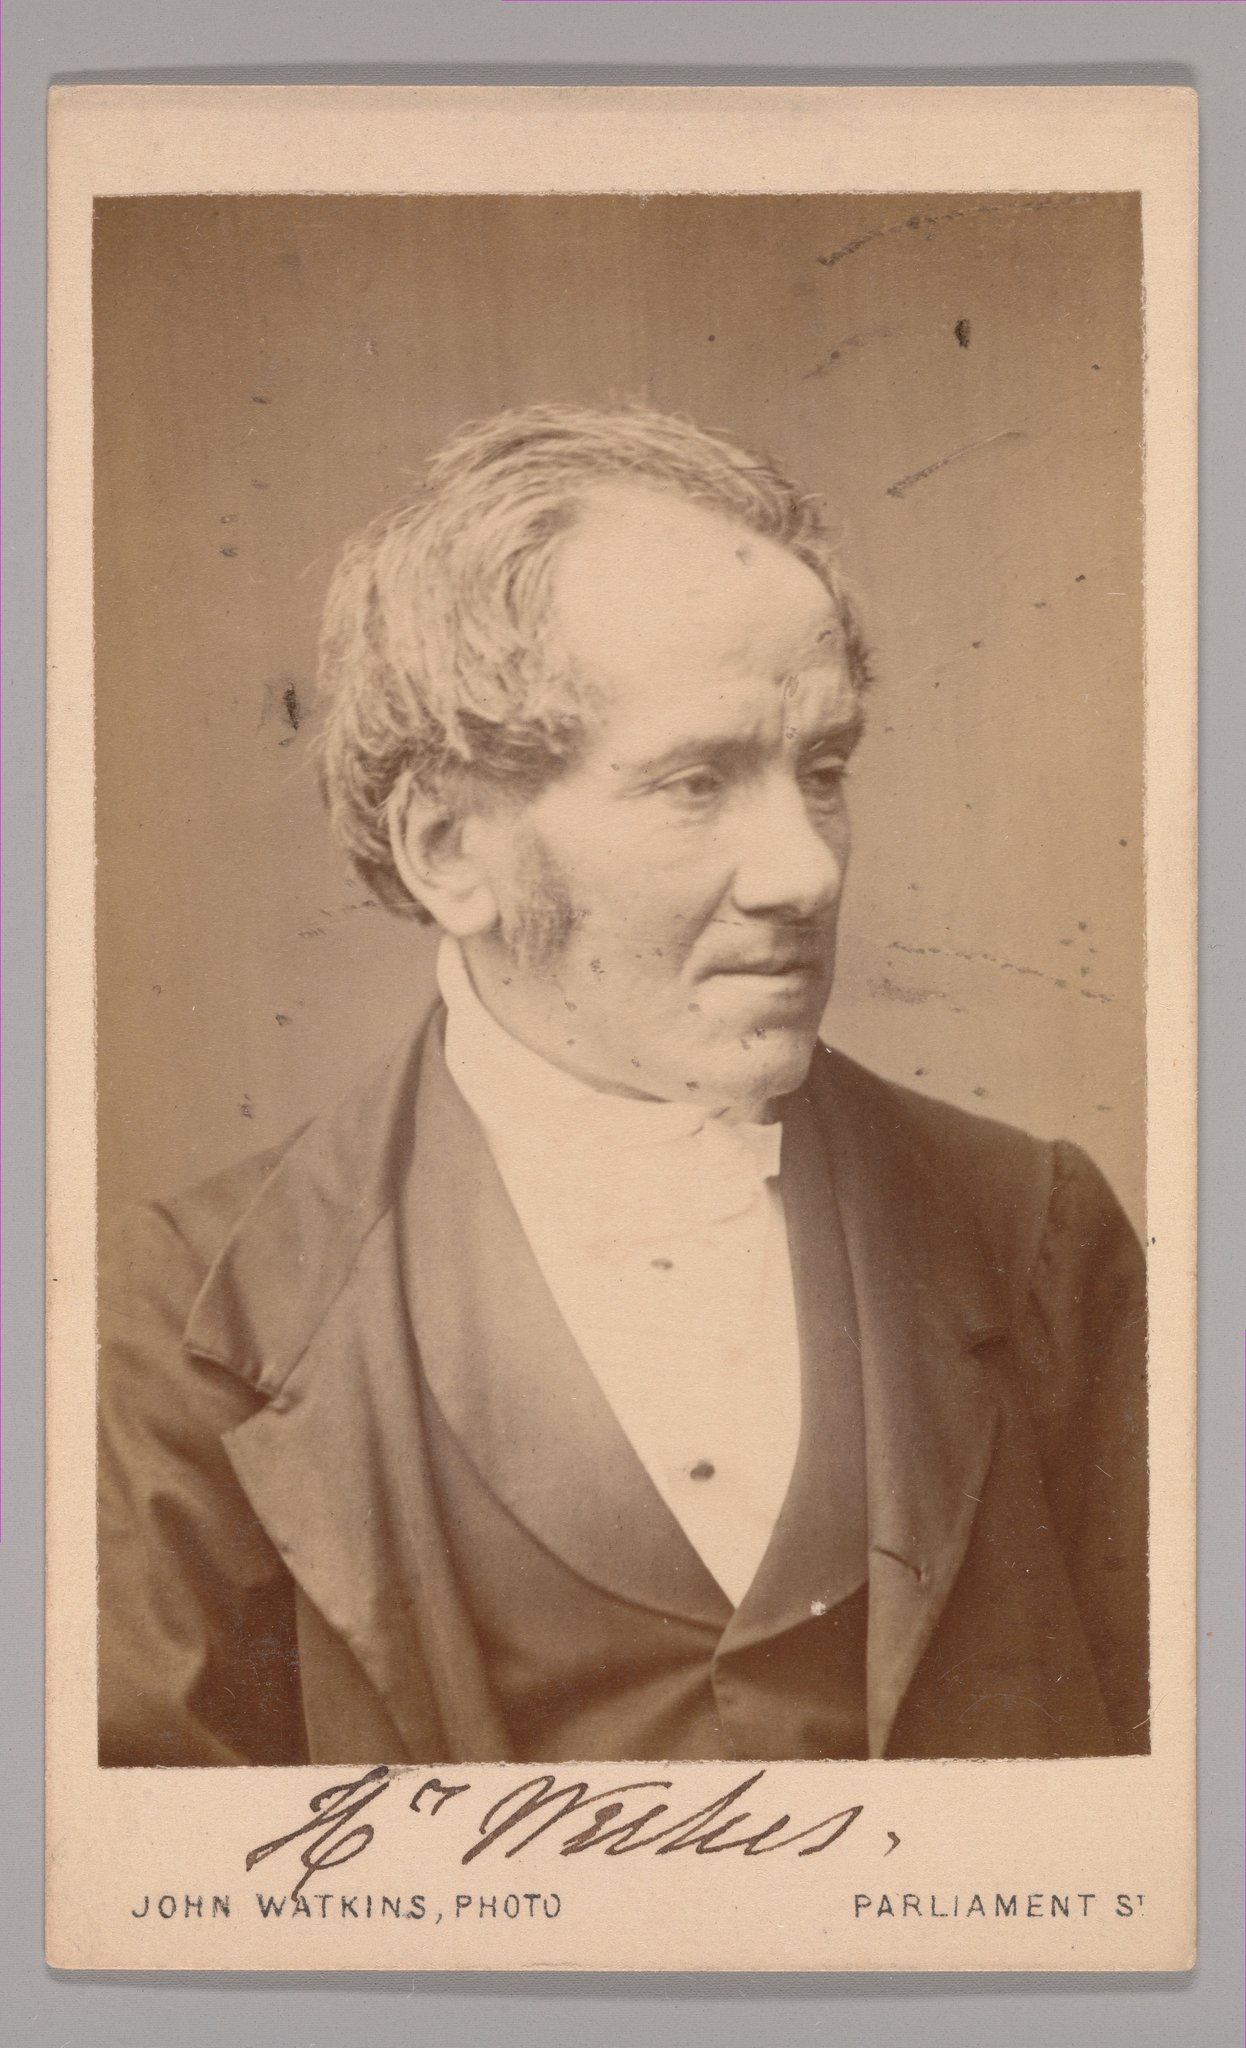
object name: carte de visite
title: [Henry Weekes]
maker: john and charles watkins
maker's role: photography studio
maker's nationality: british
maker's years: 1840-1875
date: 1860-1869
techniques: albumen silver print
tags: men,portraits